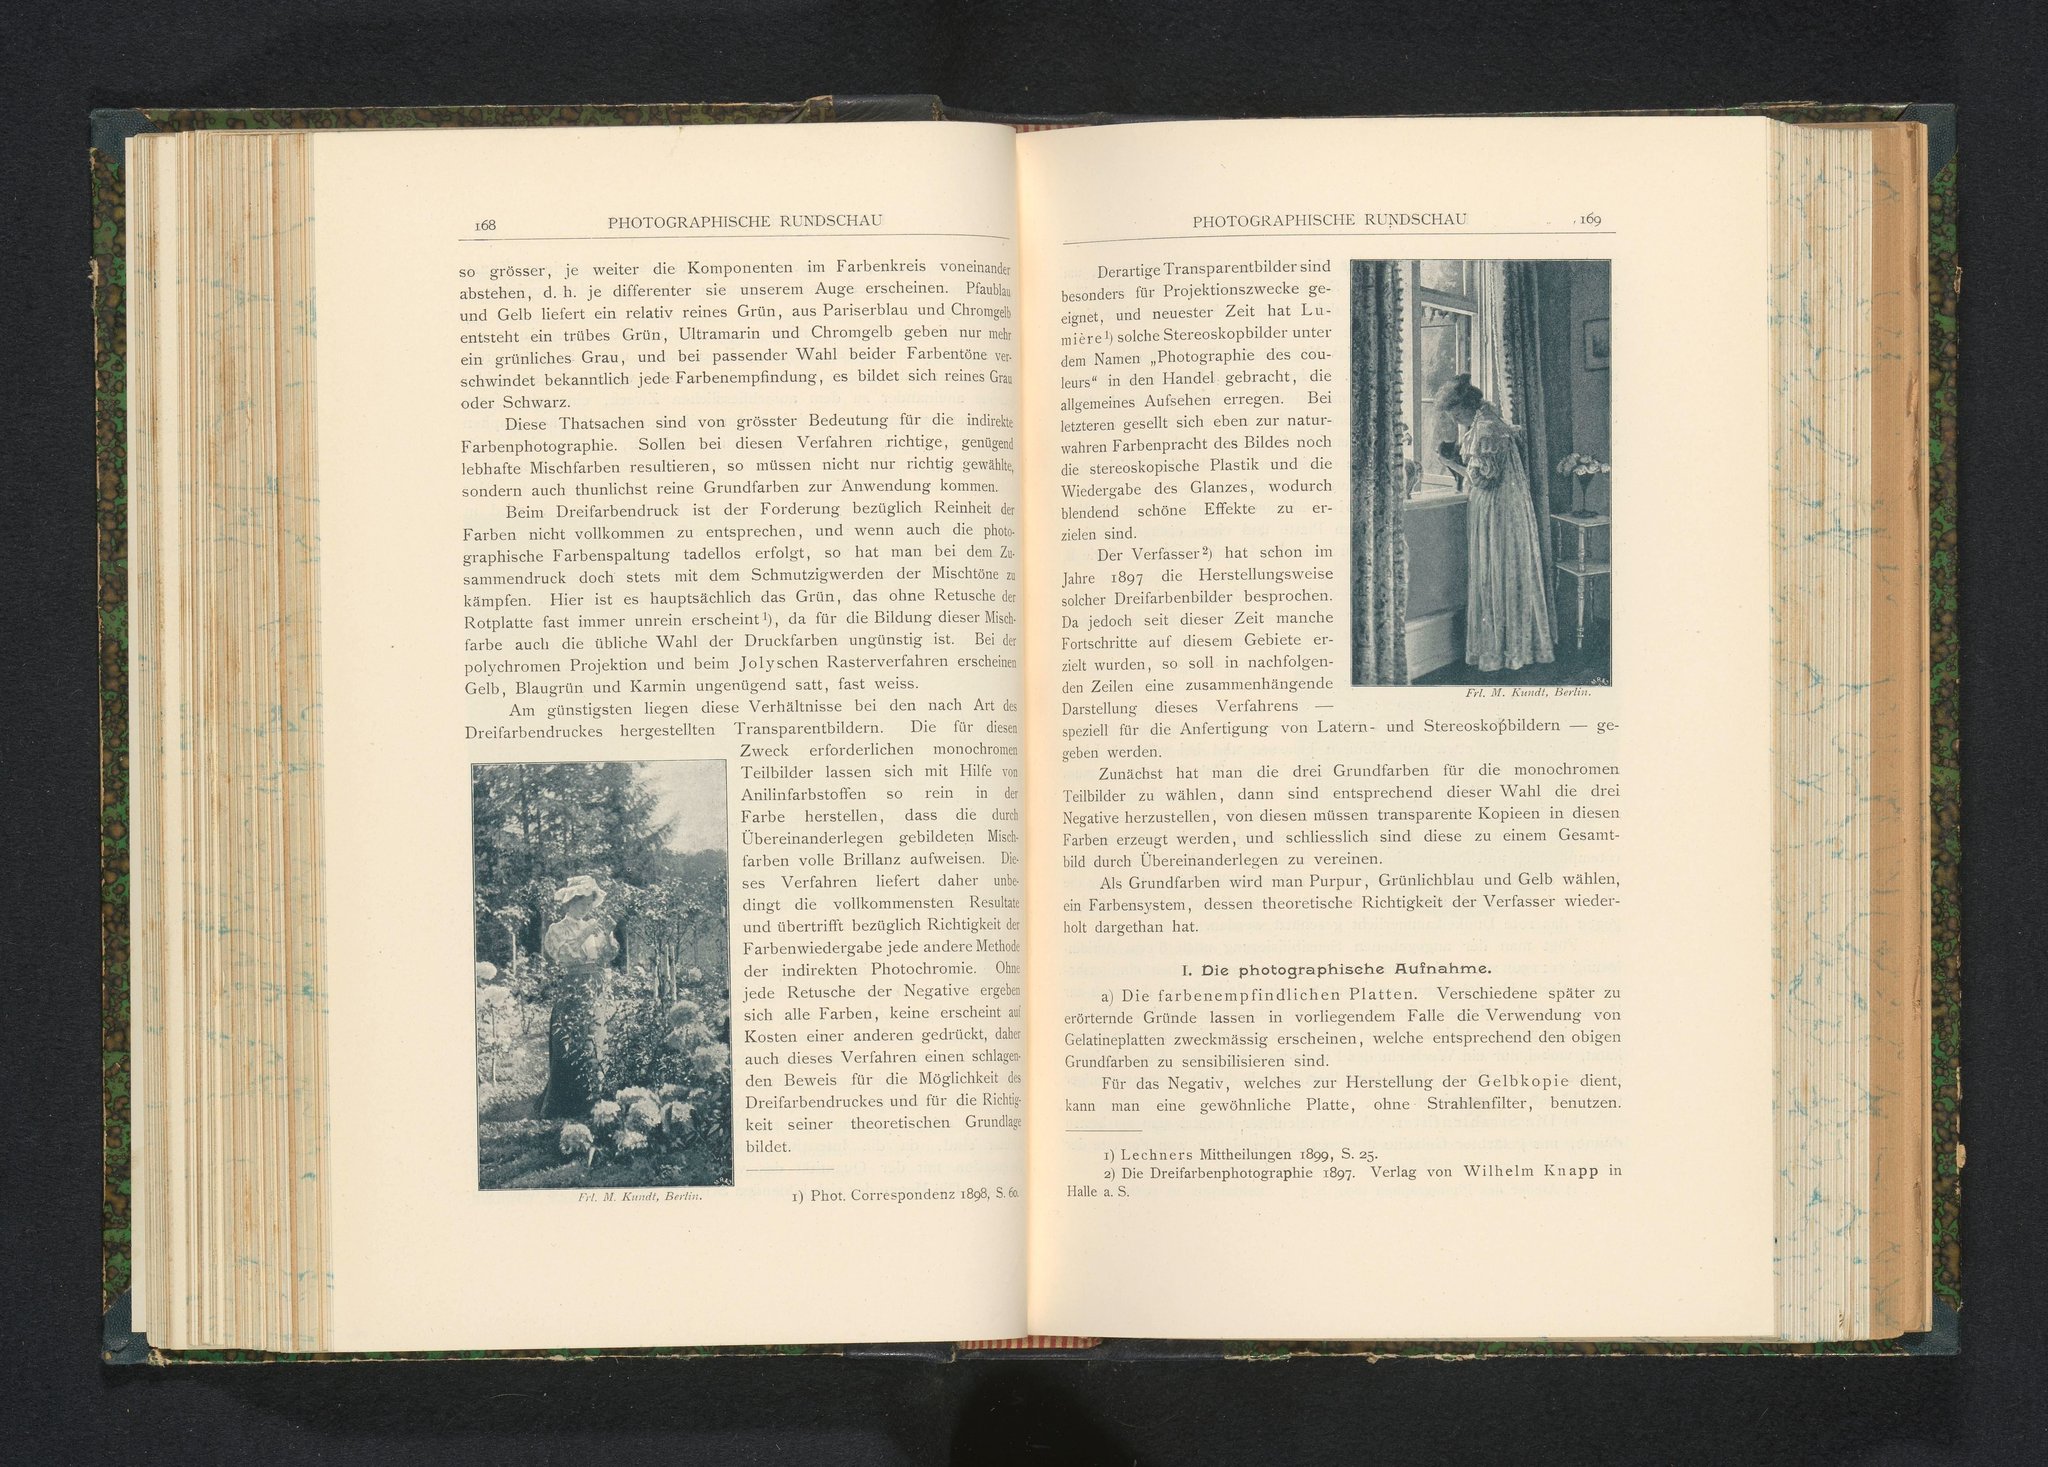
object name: page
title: Portret van een onbekende vrouw in een tuin met bloemen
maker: marie kundt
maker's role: fotograaf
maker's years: 1870-1932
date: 1894-1899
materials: paper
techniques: autotype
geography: berlin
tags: flowers, historical persons not known by name - bb - woman, garden